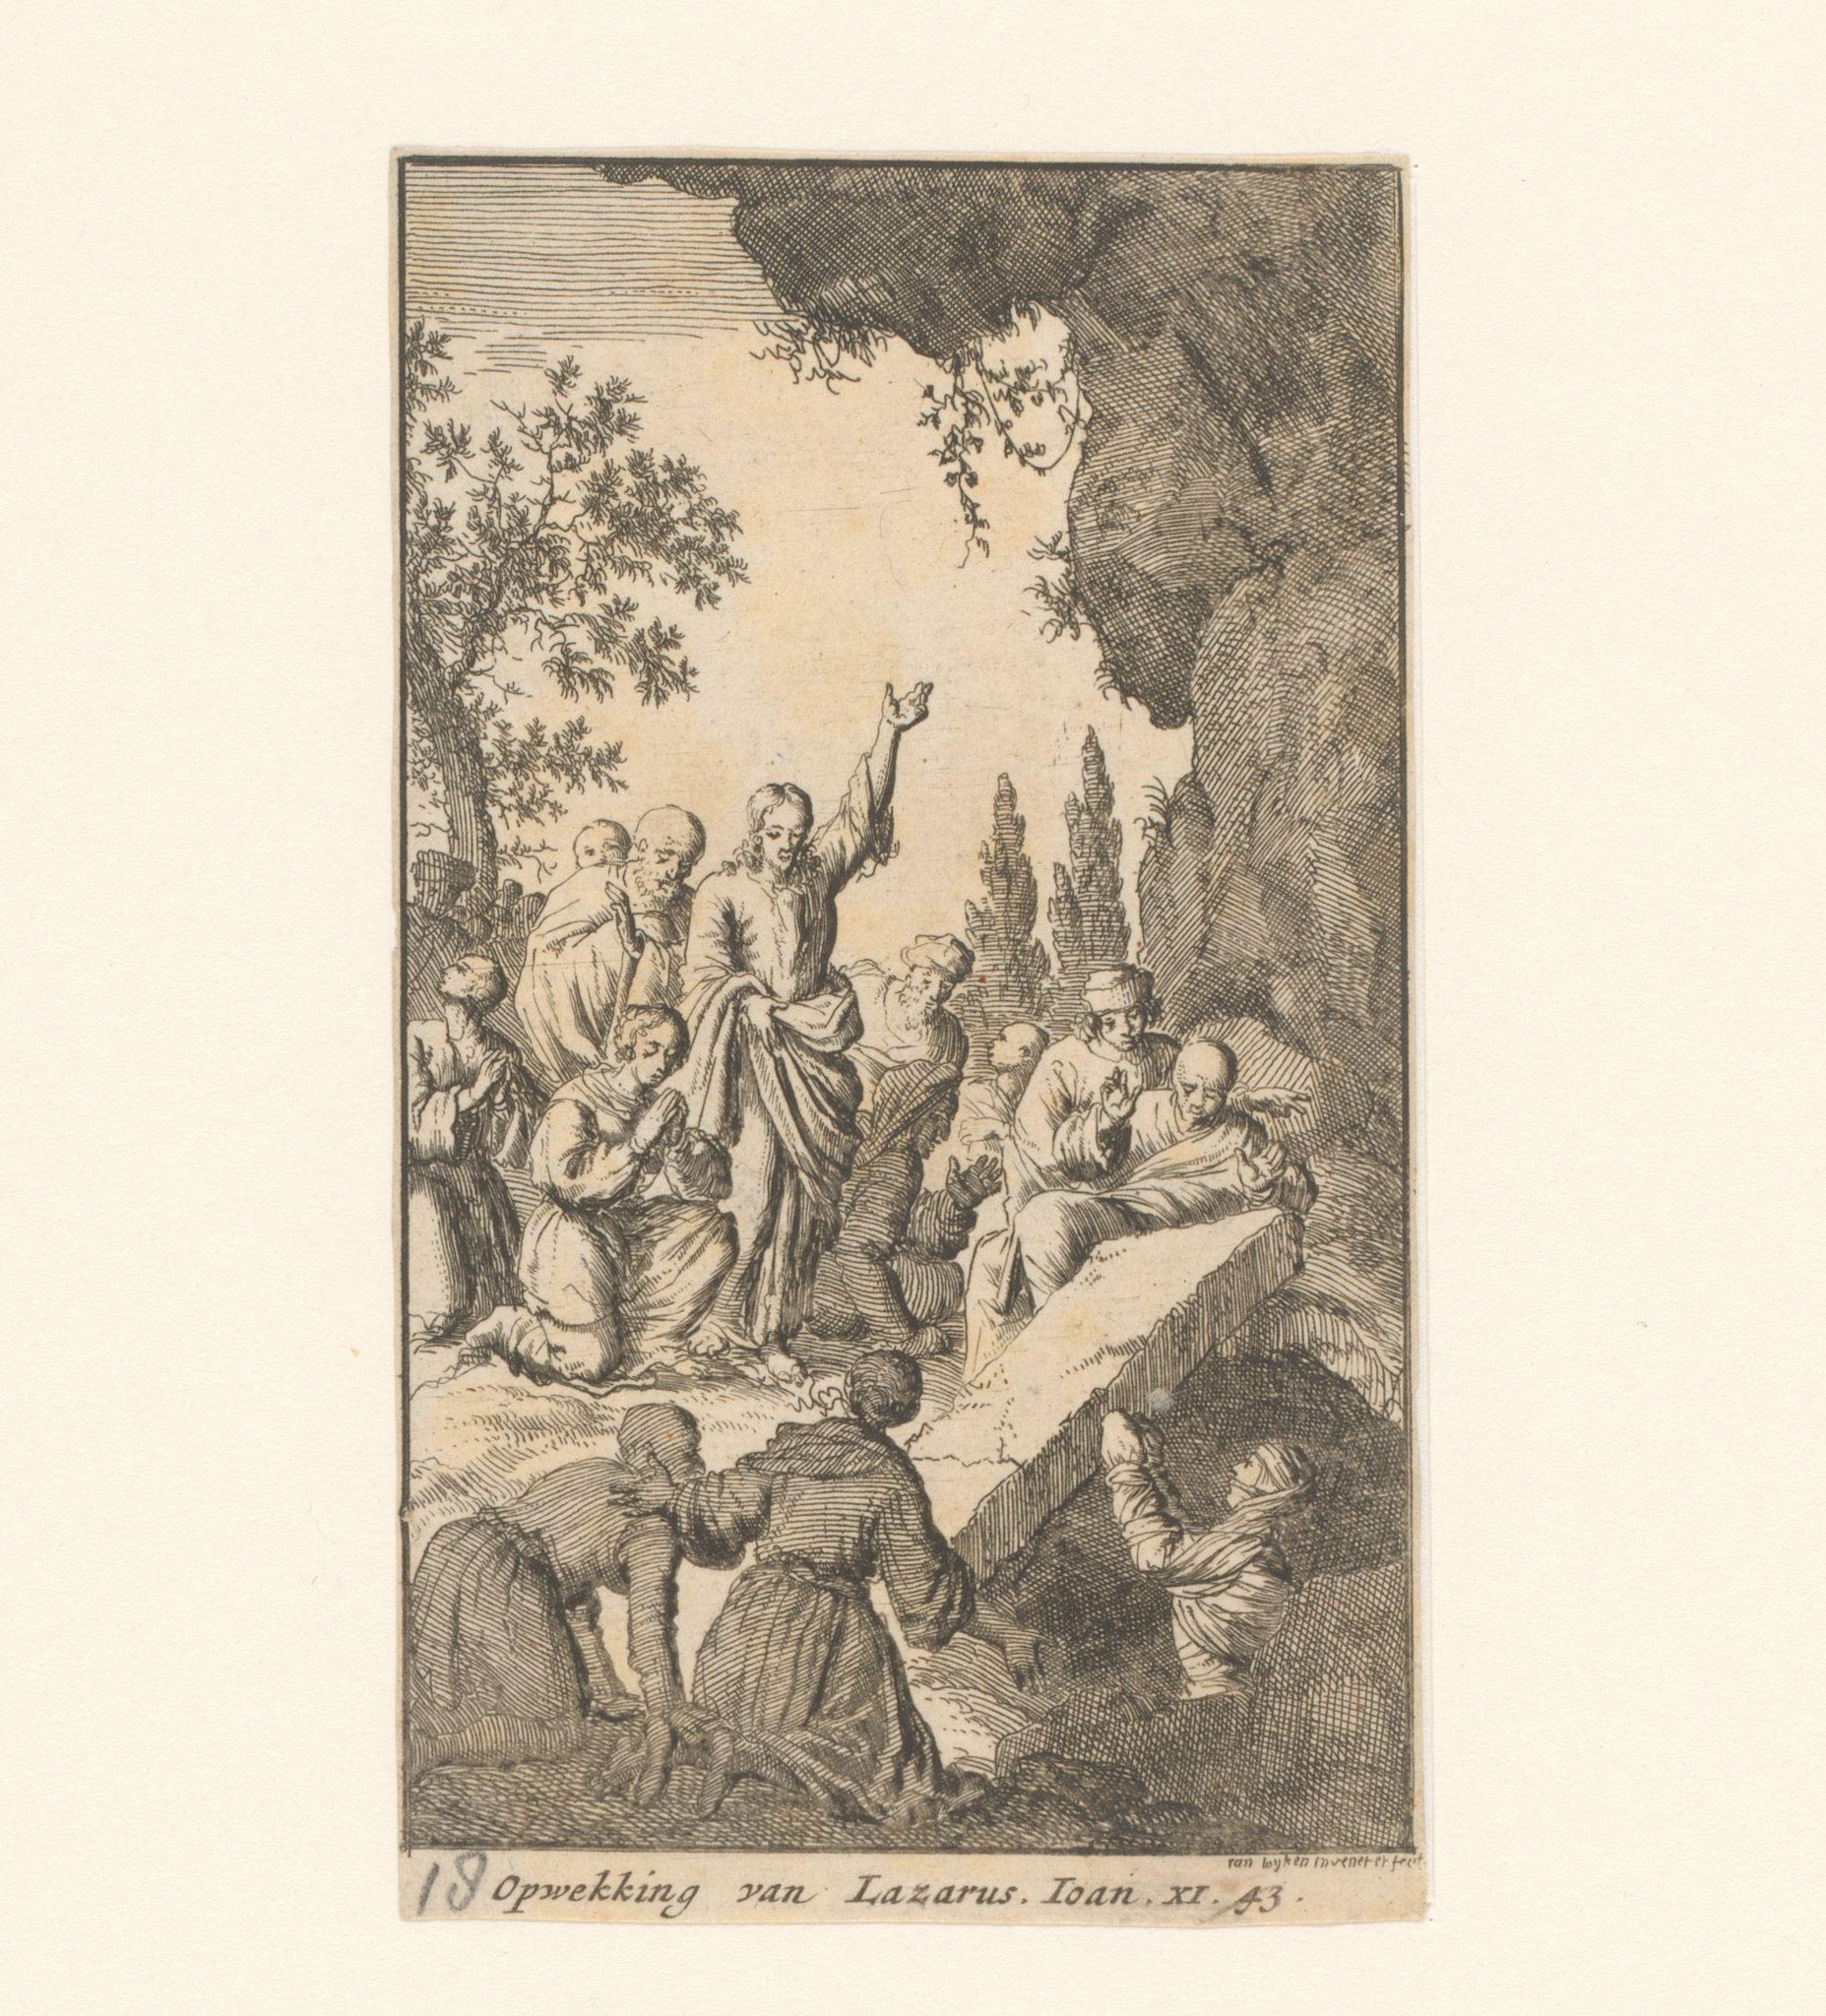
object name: print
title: Opwekking van Lazarus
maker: jan luyken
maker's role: draughtsman, print maker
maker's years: 1649-1712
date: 1669-1712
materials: paper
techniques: etching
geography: amsterdam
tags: the raising of lazarus ('lazarus, come out')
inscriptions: collector's mark: Lugt 240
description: Deze prent, en kopiëen ervan, werd veel gebruikt in Nieuwe Testamenten, onder andere in: Het Nieuwe Testament ofte alle Boecken des Nieuwen Verbondts onses Heeren Iesu Christi. Dordrecht: Pieter en Jacob Keur, 172X (niet voor 1727). In dit werk is de complete vierentwintigdelige serie opgenomen.